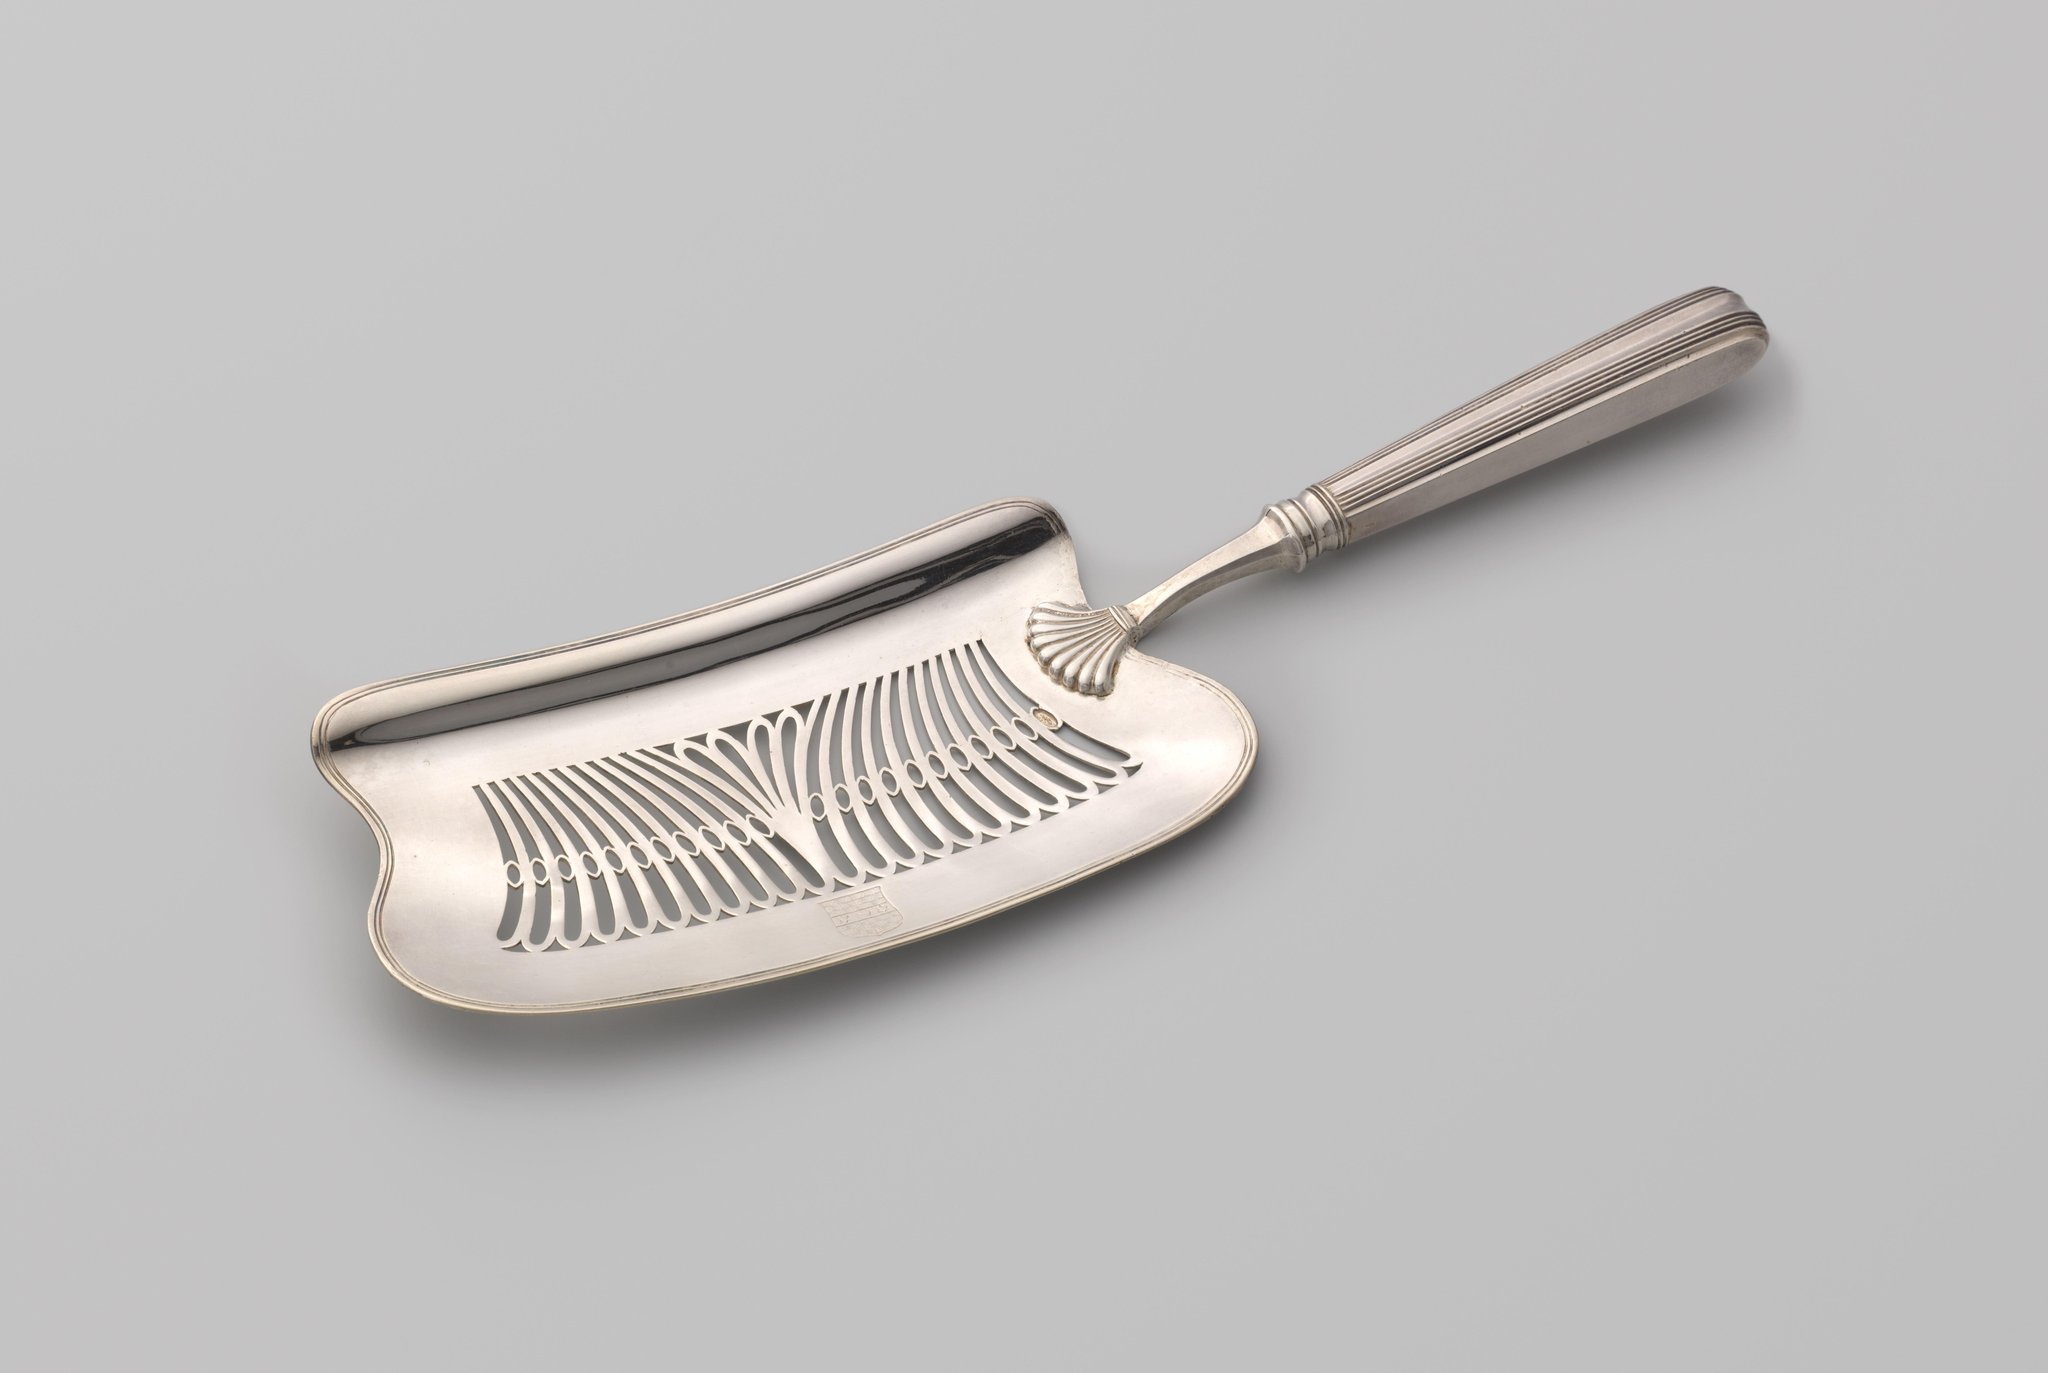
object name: visschep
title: Visschep met het familiewapen Clifford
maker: weduwe j.h. stellingwerff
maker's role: silversmith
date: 1824-1837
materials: silver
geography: amsterdam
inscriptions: maker's mark, alloy mark, hallmark: ‘zwaardje’, assay office mark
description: De trapeziumvormige, licht gewelfde, aan de korte zijden ingesnoerde schep is opengewerkt met een symmetrisch patroon van uitwaaierende knerren waarin ovalen. De schep heeft aan de bovenzijde een gegraveerde dubbele filetrand en is aan een korte zijde door middel van een gelobde waaiervormige aanzet verbonden met de naar het einde toe zich verbredende steel, die licht gebogen en gefacetteerd is. Hieraan is door middel van een geprofileerde ring het zich verbredende rechte heft bevestigd. Langs boven- en onderrand van het heft is een filetrand aangebracht. Op de bovenzijde van de schep is het wapen Clifford gegraveerd.